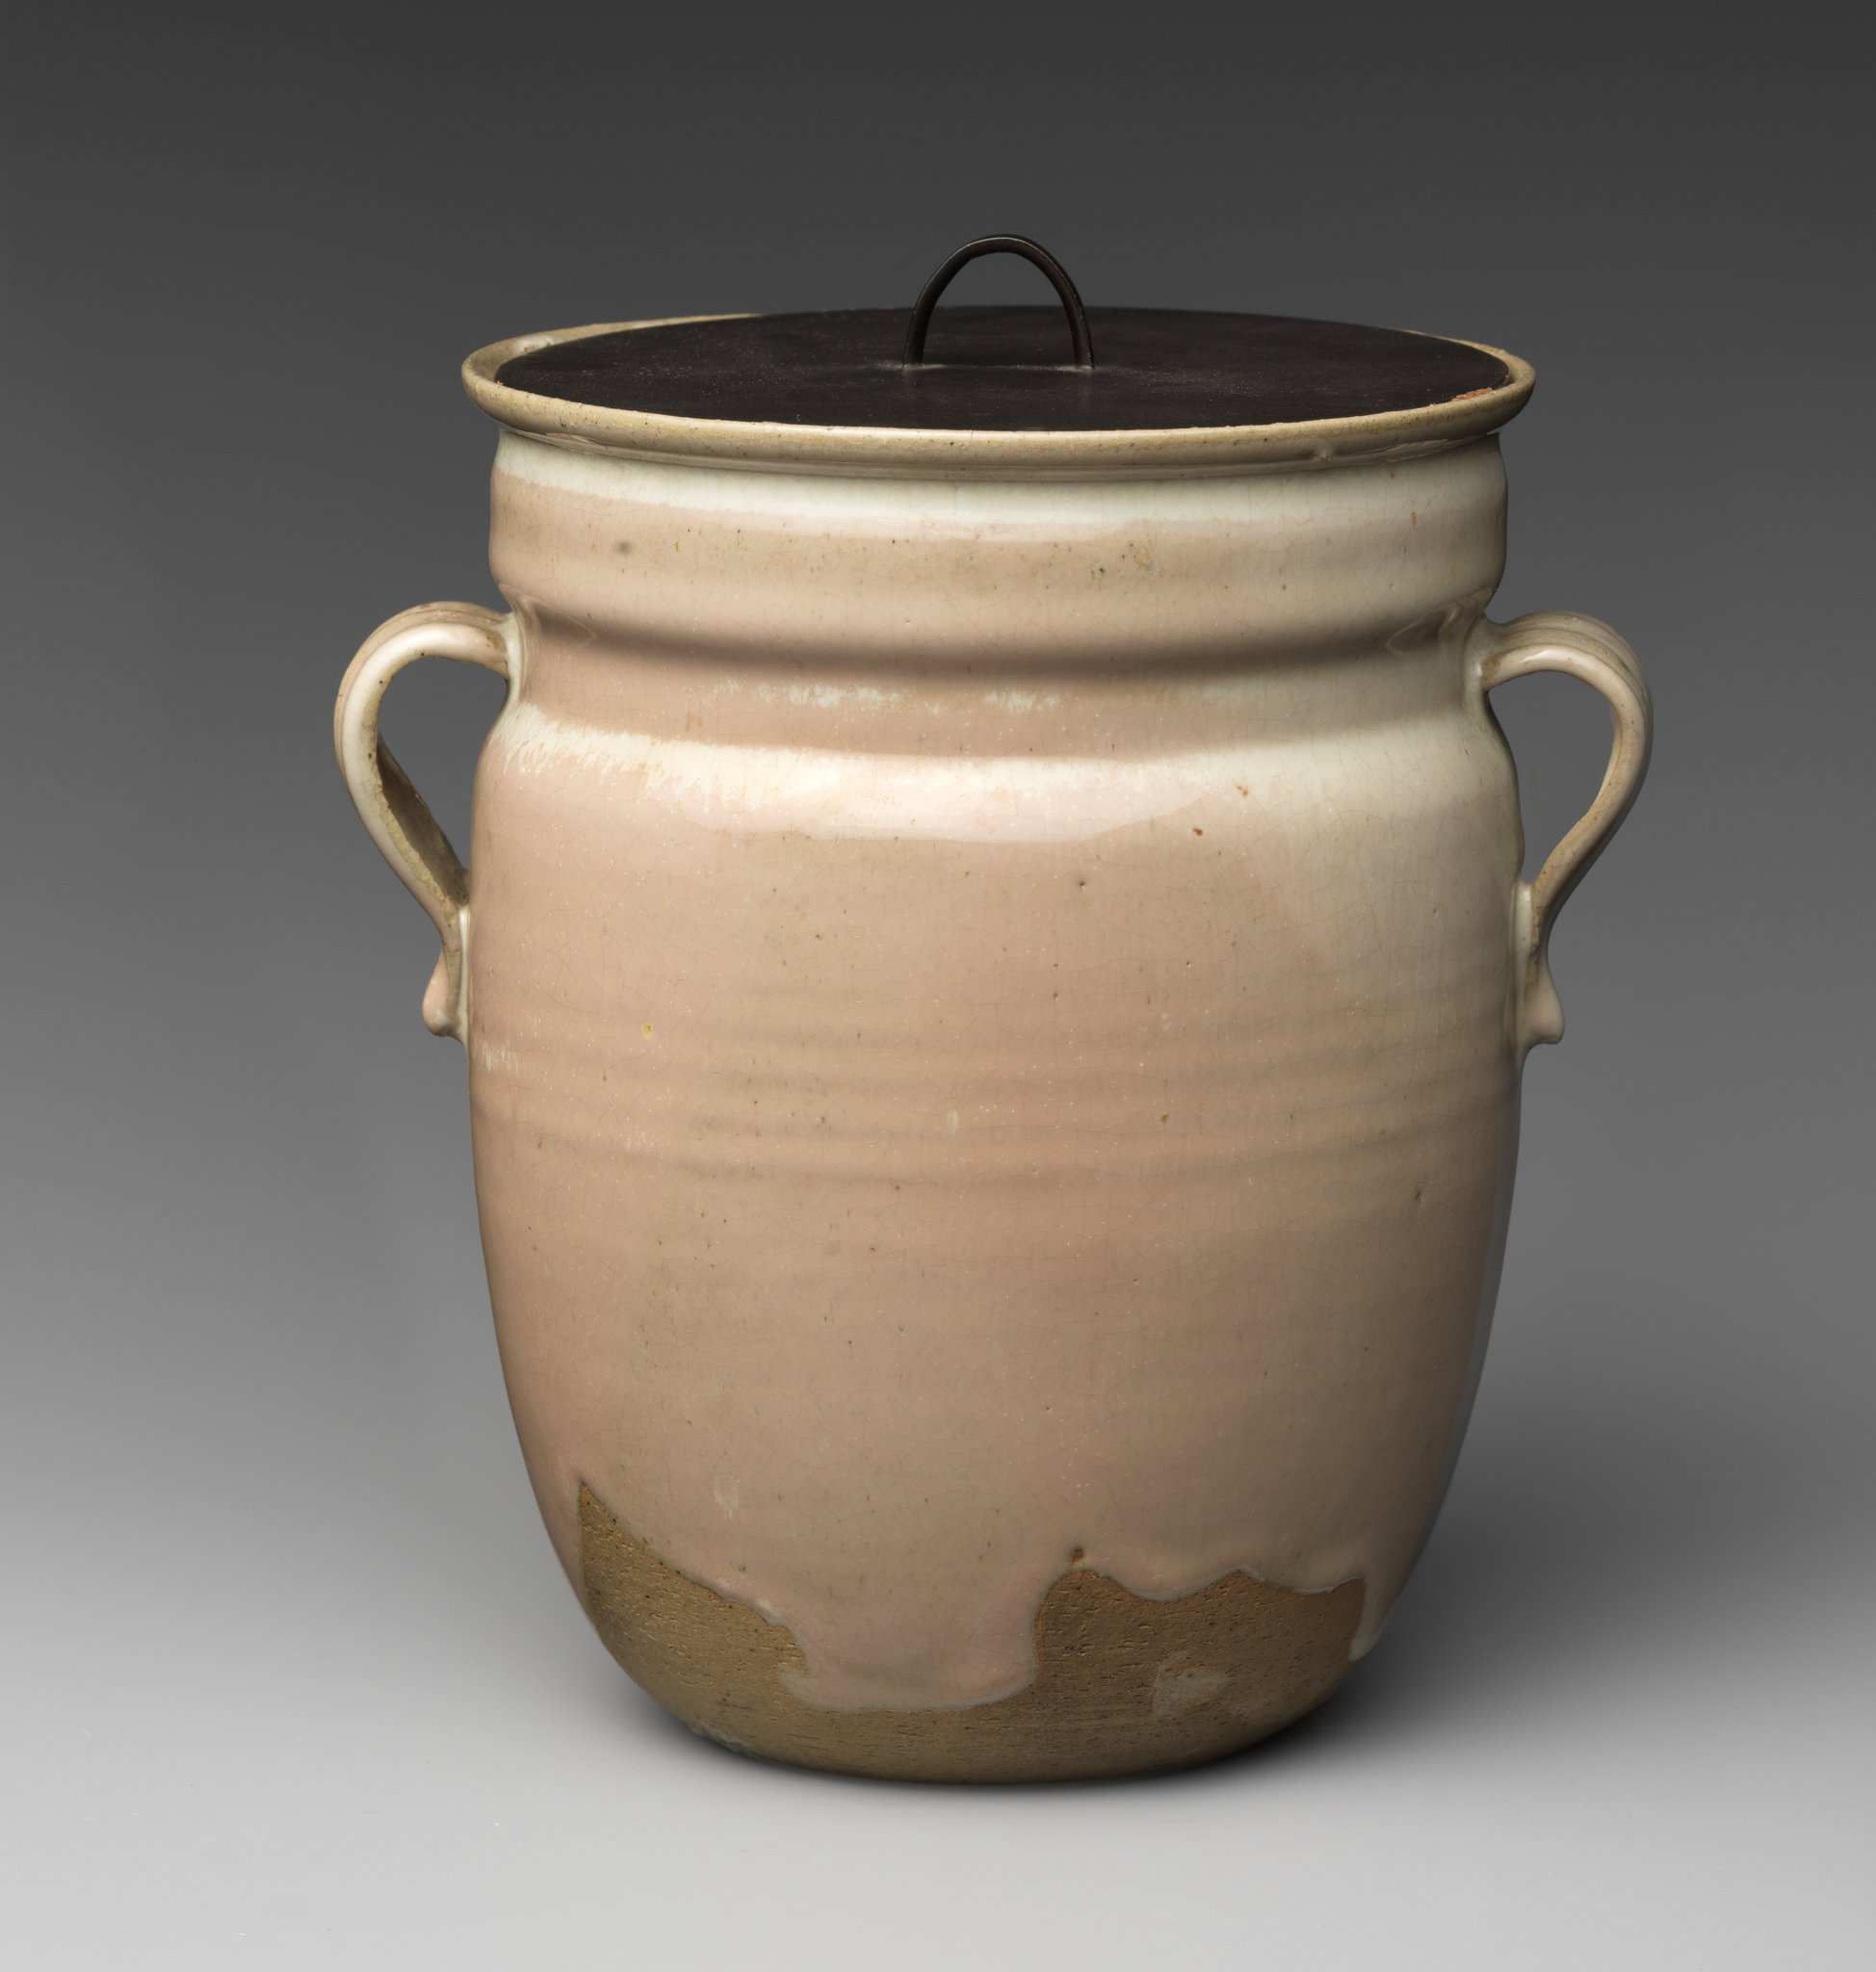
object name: water jar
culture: japanese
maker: nonomura ninsei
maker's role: artist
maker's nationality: japanese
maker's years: 1646-1694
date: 1601-1700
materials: glaze, pottery